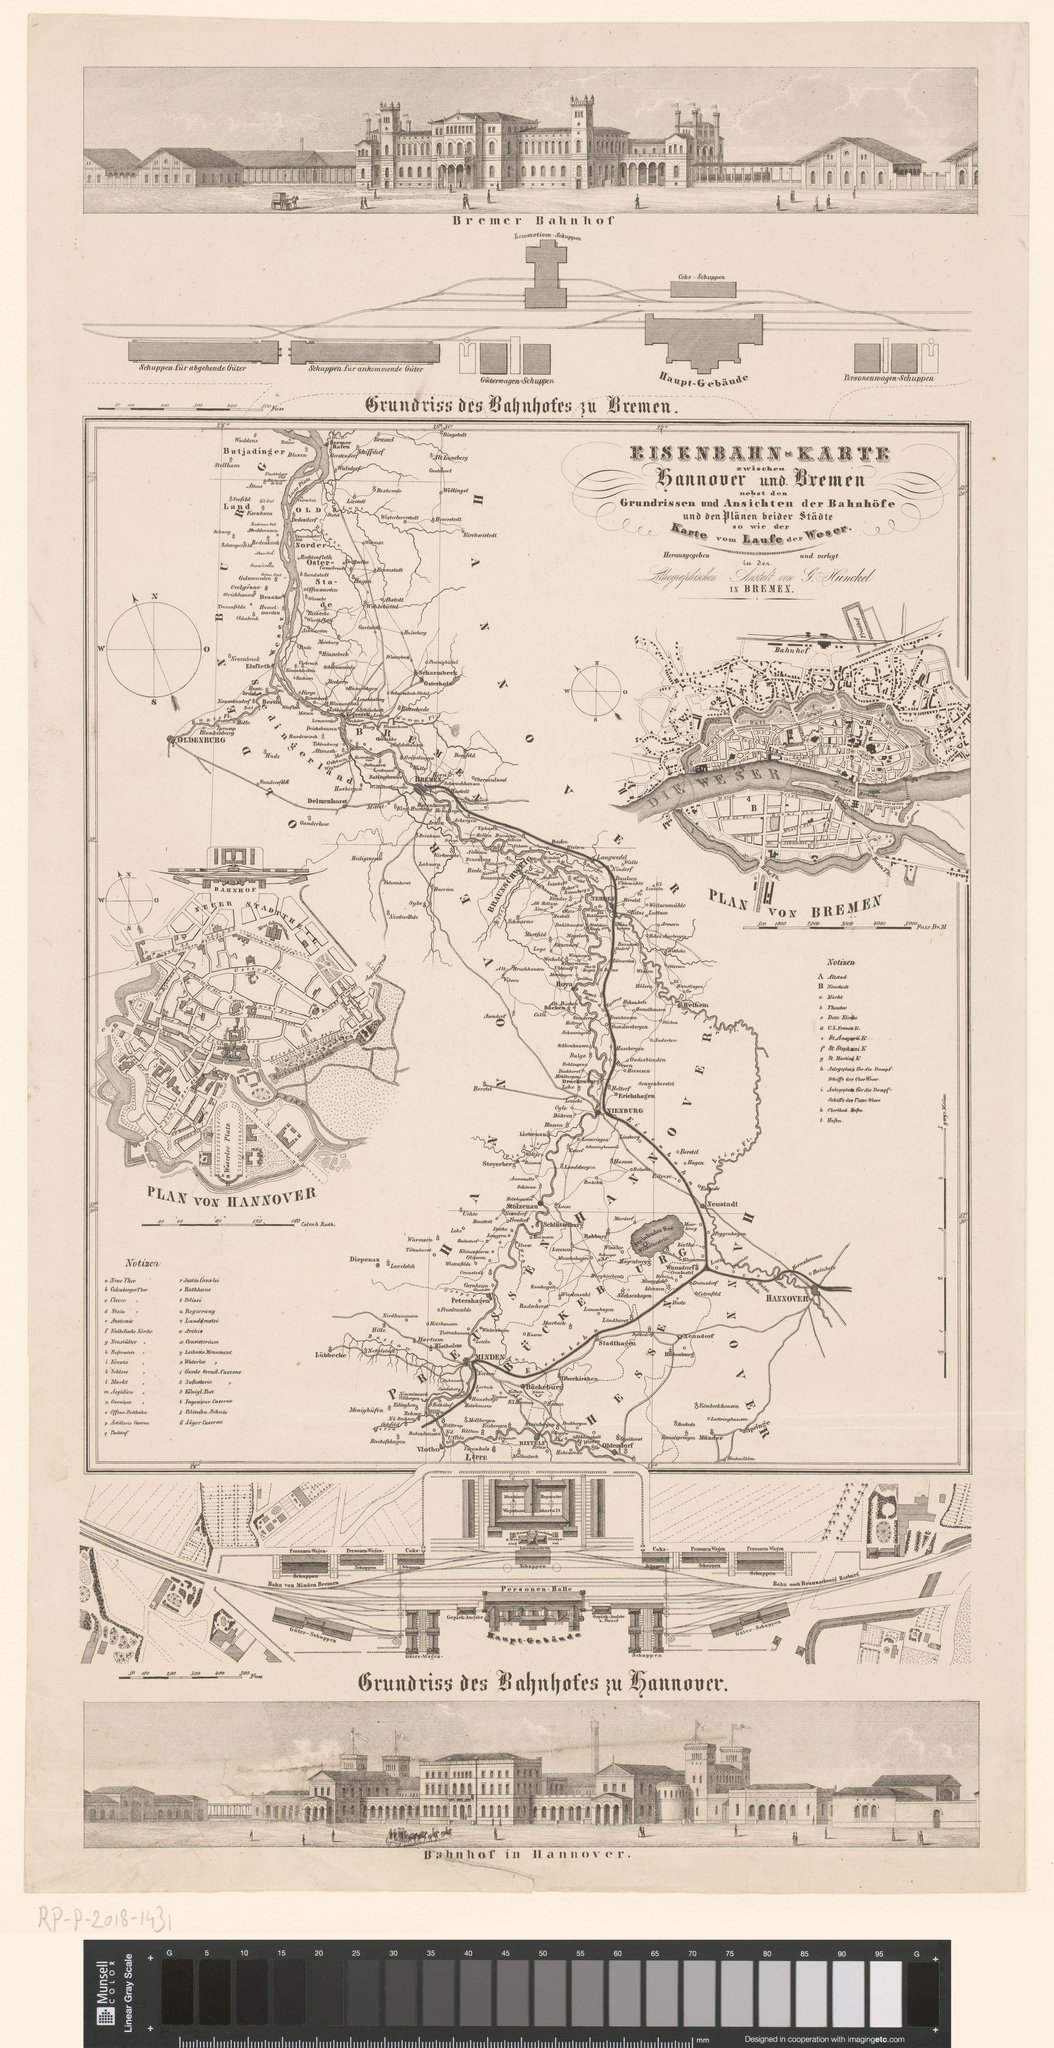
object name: area plan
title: Eisenbahn-Karte zwischen Honnover und Bremen nebst den Grundrissen (...)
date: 1847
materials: paper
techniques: lithograph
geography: bremen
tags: railway, train, station; shelter (railway, tramway), maps of cities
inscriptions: collector's mark: Lugt 2228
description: Kaart van de spoorweg tussen Hannover en Bremen. Boven een gezicht op en een plattegrond van het treinstation van Bremen. Onder een gezicht op en een plattegrond van het treinstation van Hannover. Links in de kaart een plattegrond van Hannover, rechts een plattegrond van Bremen.